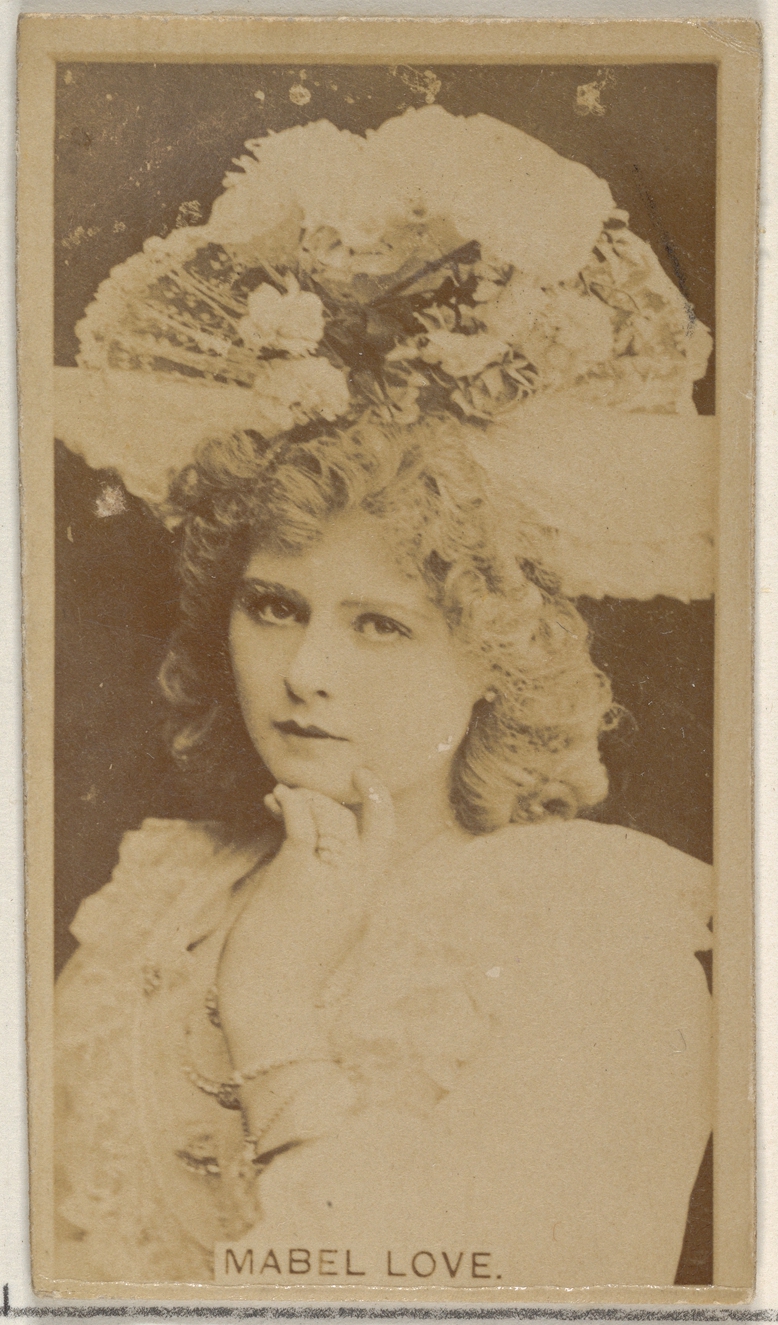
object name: photograph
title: Mabel Love, from the Actors and Actresses series (N45, Type 8) for Virginia Brights Cigarettes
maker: allen & ginter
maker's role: publisher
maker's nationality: american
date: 1888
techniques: albumen silver print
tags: portraits,women,dancers